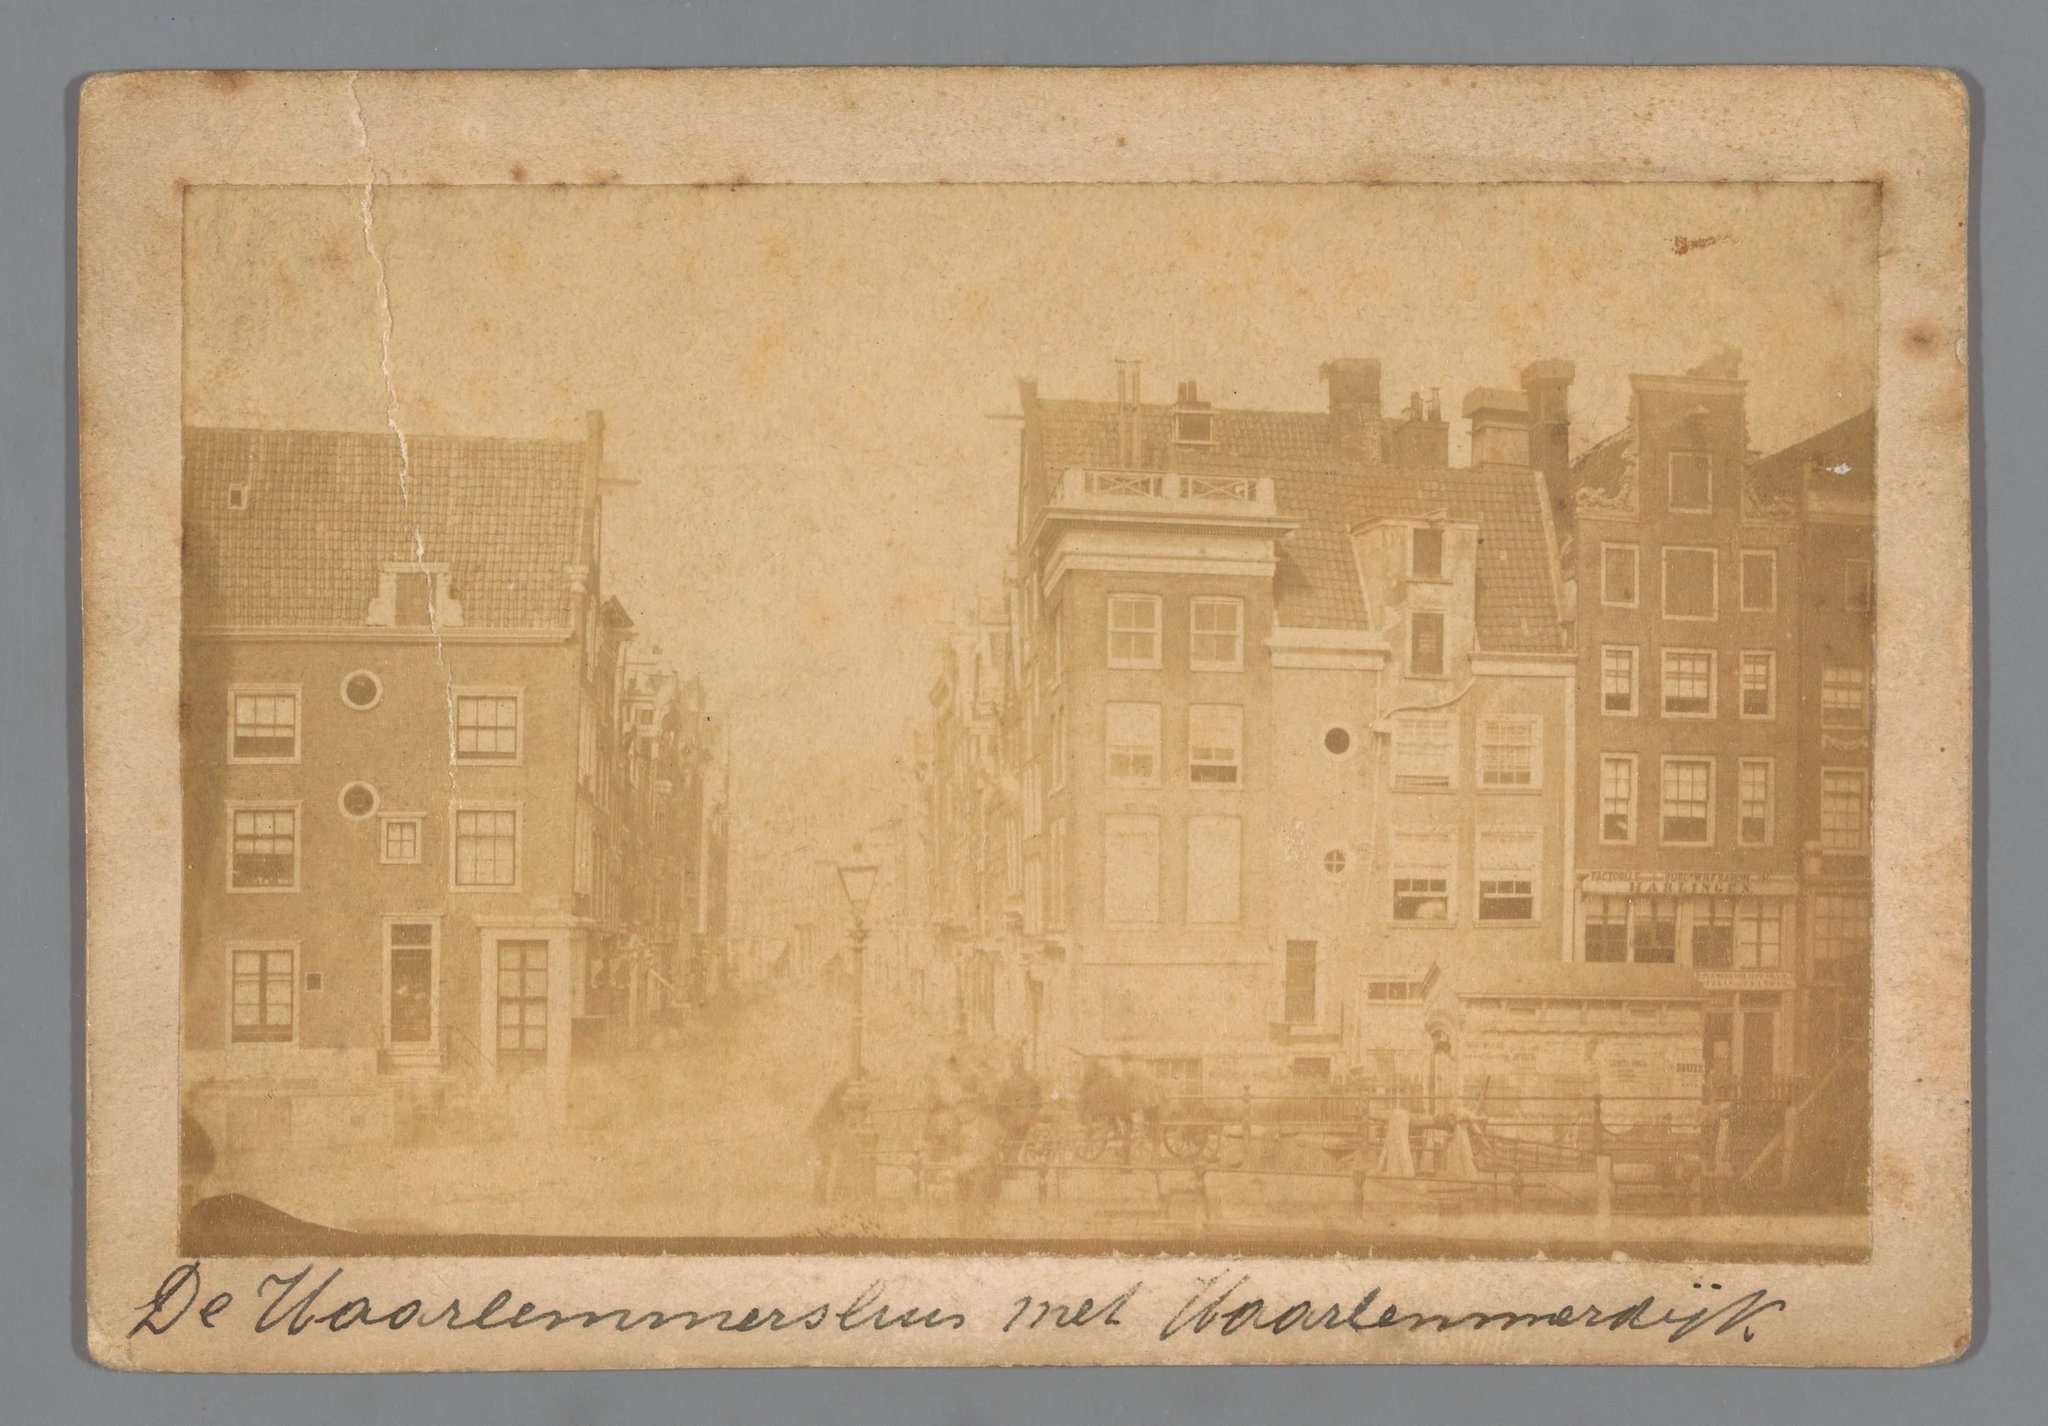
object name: photograph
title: Gezicht op de Haarlemmerdijk in Amsterdam, met op de voorgrond de Haarlemmersluis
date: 1850-1880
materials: cardboard, photographic support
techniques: albumen print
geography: amsterdam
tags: street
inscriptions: inscription: ‘38 HAARLEMMERDIJK/ Boekhandel. - C. F. Stemler. - Amsterdam.’, annotation: ‘De Haarlemmersluis met Haarlemmerdijk.’